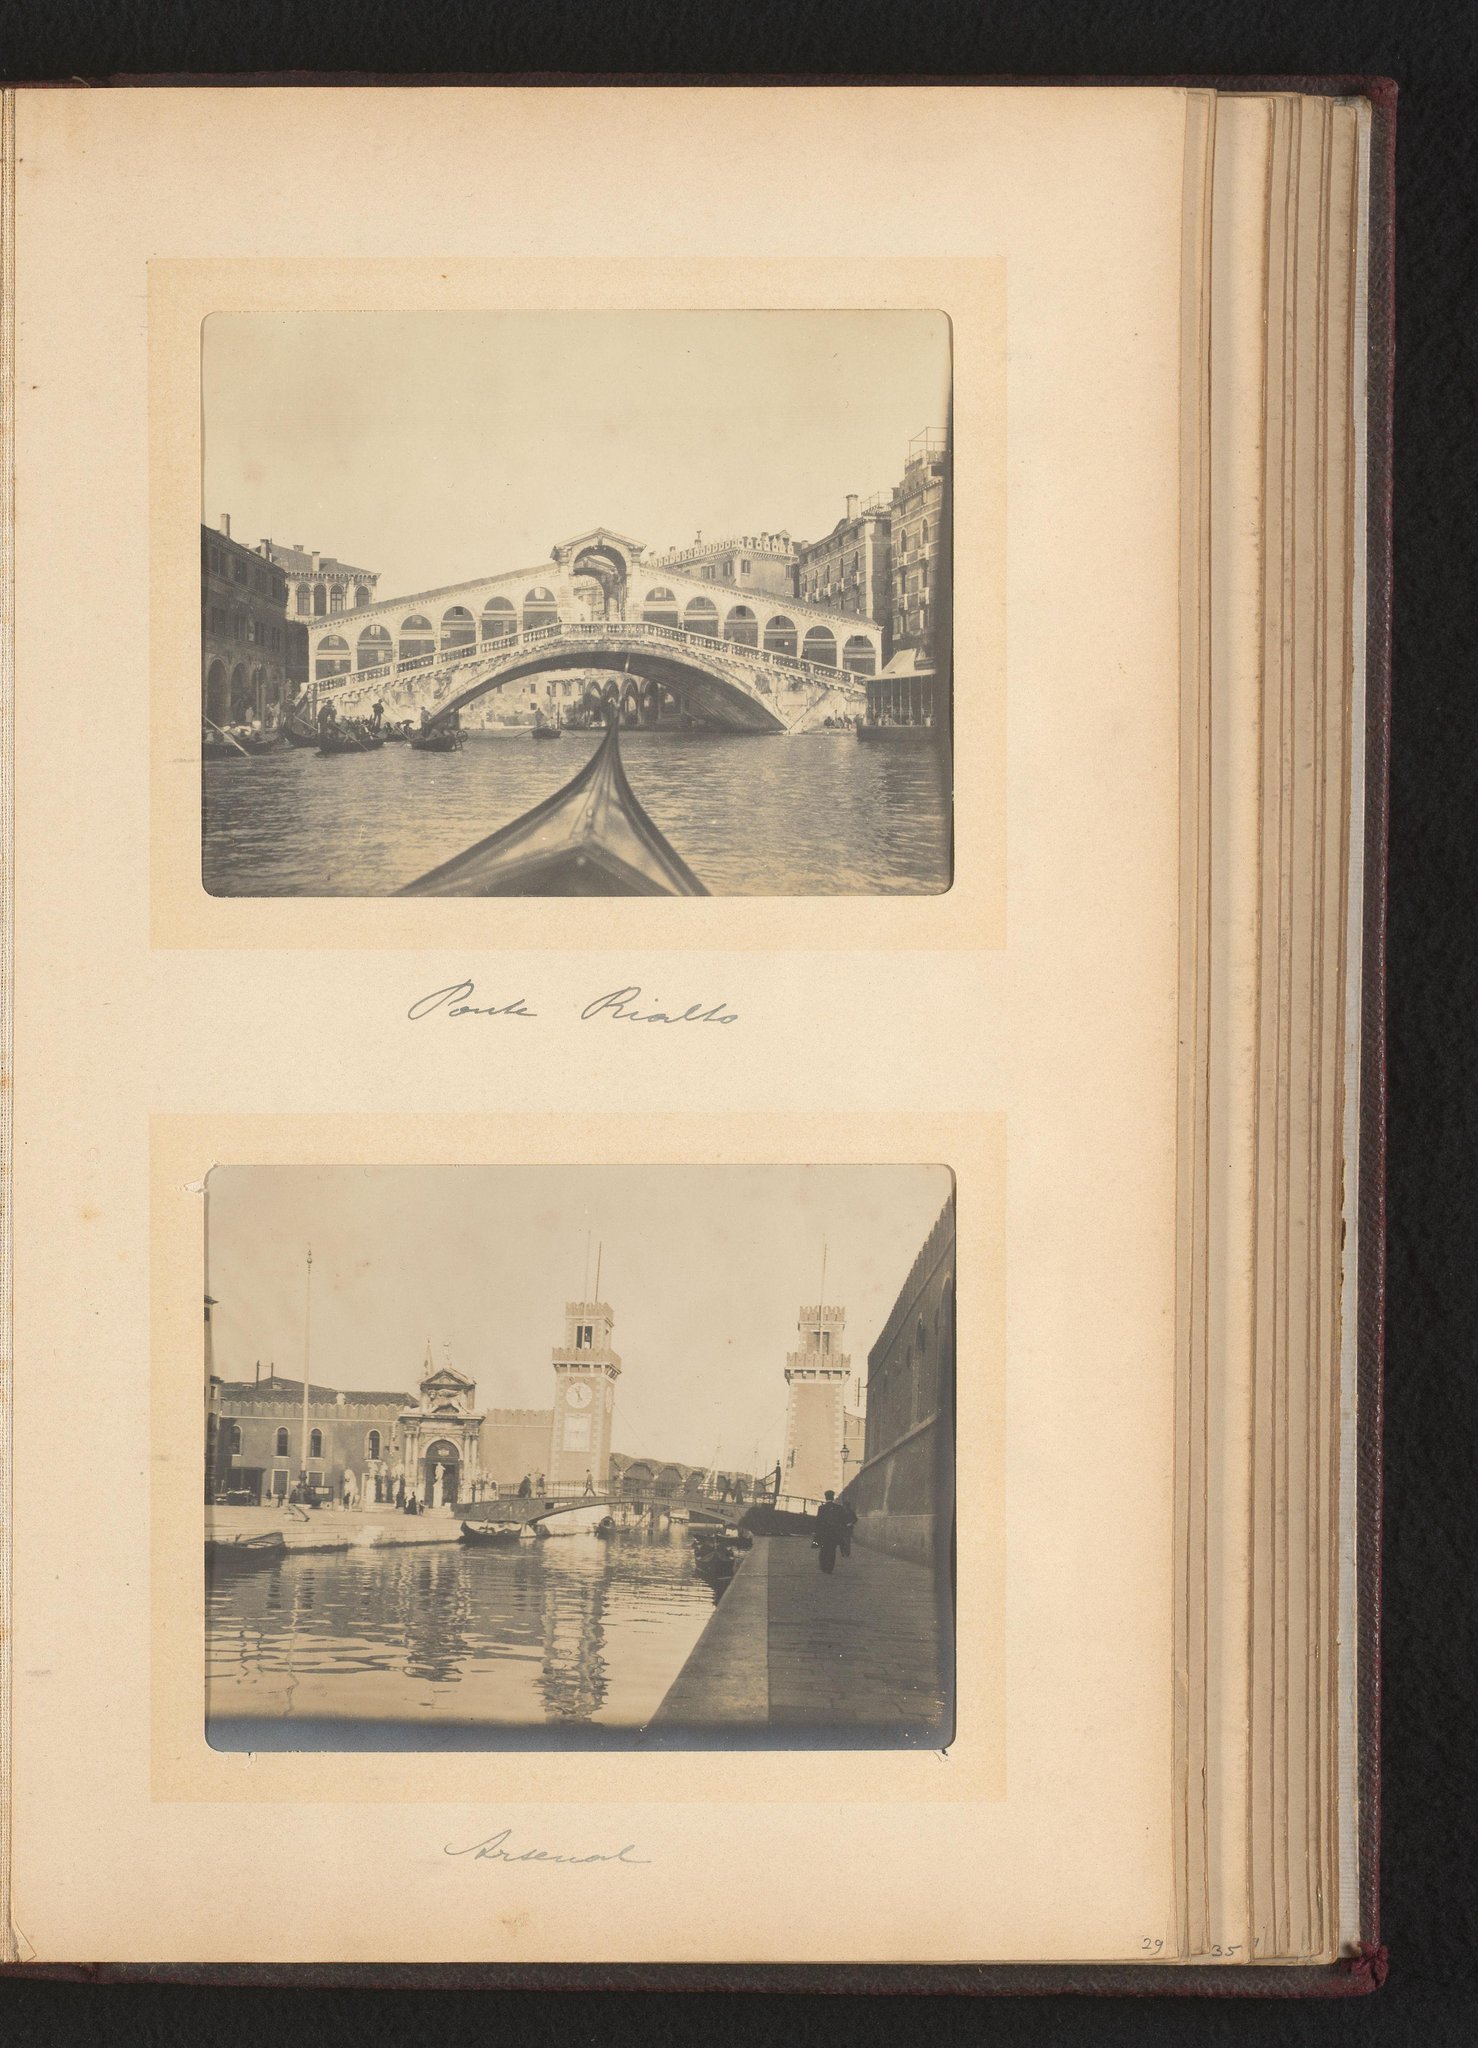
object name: album leaf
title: Rialtobrug en Arsenaal van Venetië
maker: Anonymous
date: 1895-1905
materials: cardboard, photographic support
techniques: gelatin silver print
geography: venice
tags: tourism, bridge in city across river, canal, etc., square, place, circus, etc. (+ city(-scape) with figures, staffage), ammunition store, arsenal, venice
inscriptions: inscription: ‘Ponte Rialto / Arsenal’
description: Albumblad met twee foto's in Venetië. Onderdeel van een fotoalbum van een reis door Italië, ca. 1900.